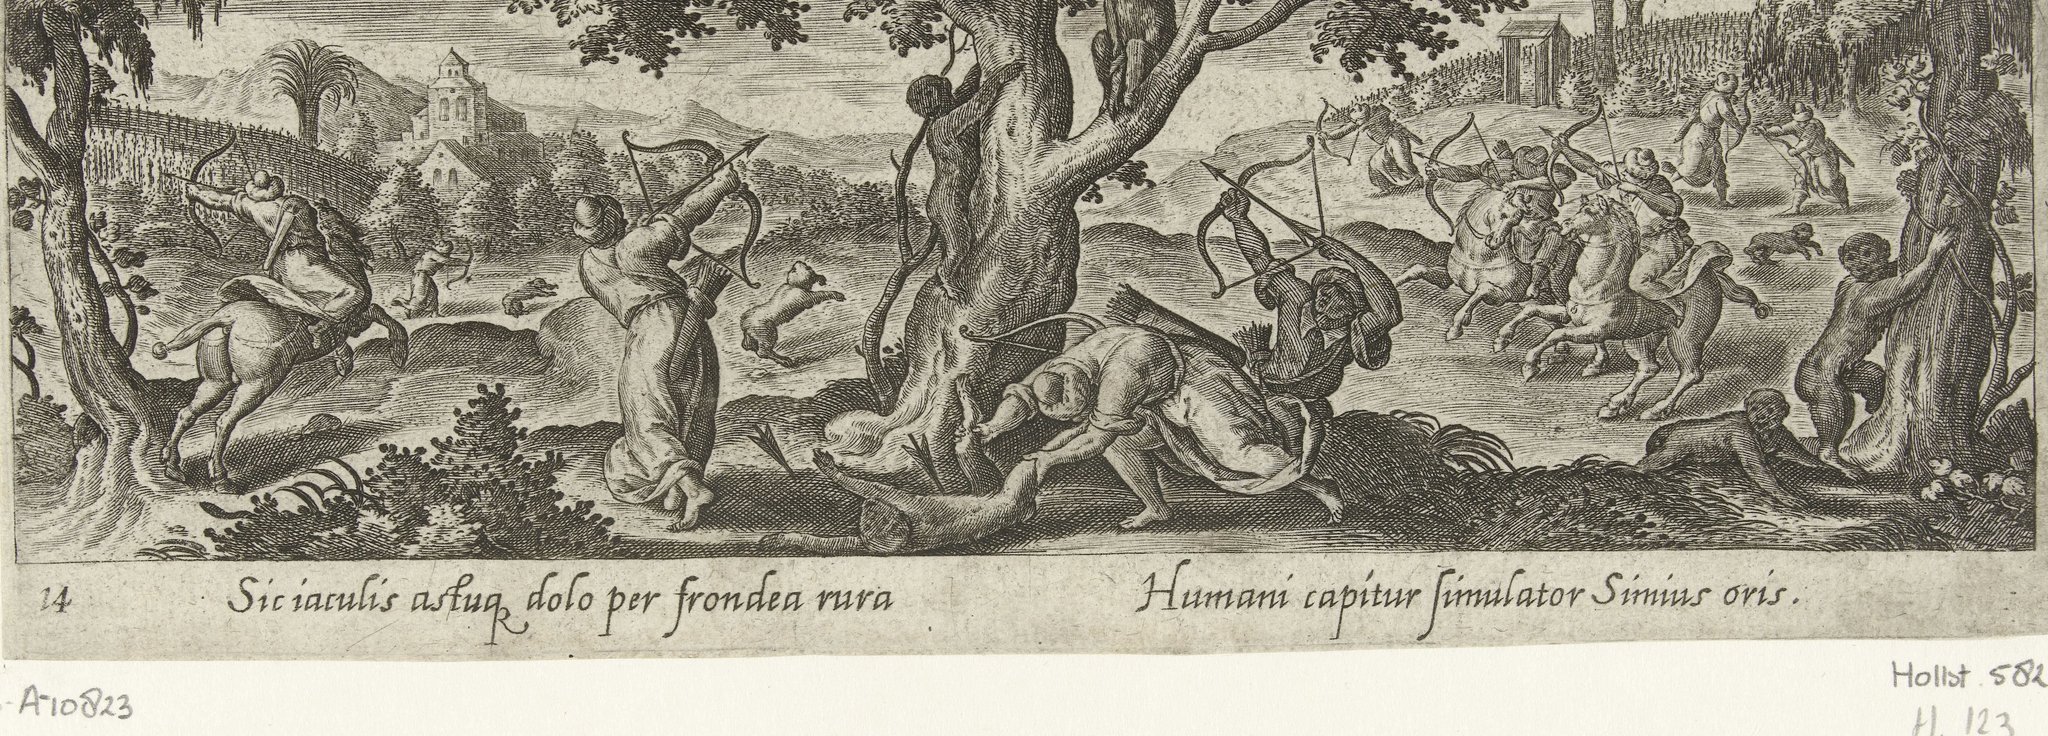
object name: print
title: Venationes, Piscationes et Aucupii Typi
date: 1582-1633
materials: paper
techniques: engraving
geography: antwerp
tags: monkeys, apes, hunt ~ other mammals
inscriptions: collector's mark: Lugt 2228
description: Ruiters en jagers te voeten schieten met pijl en boog op apen in de bomen. De prent heeft een Latijns onderschrift en maakt deel uit van een serie van 54 prenten.